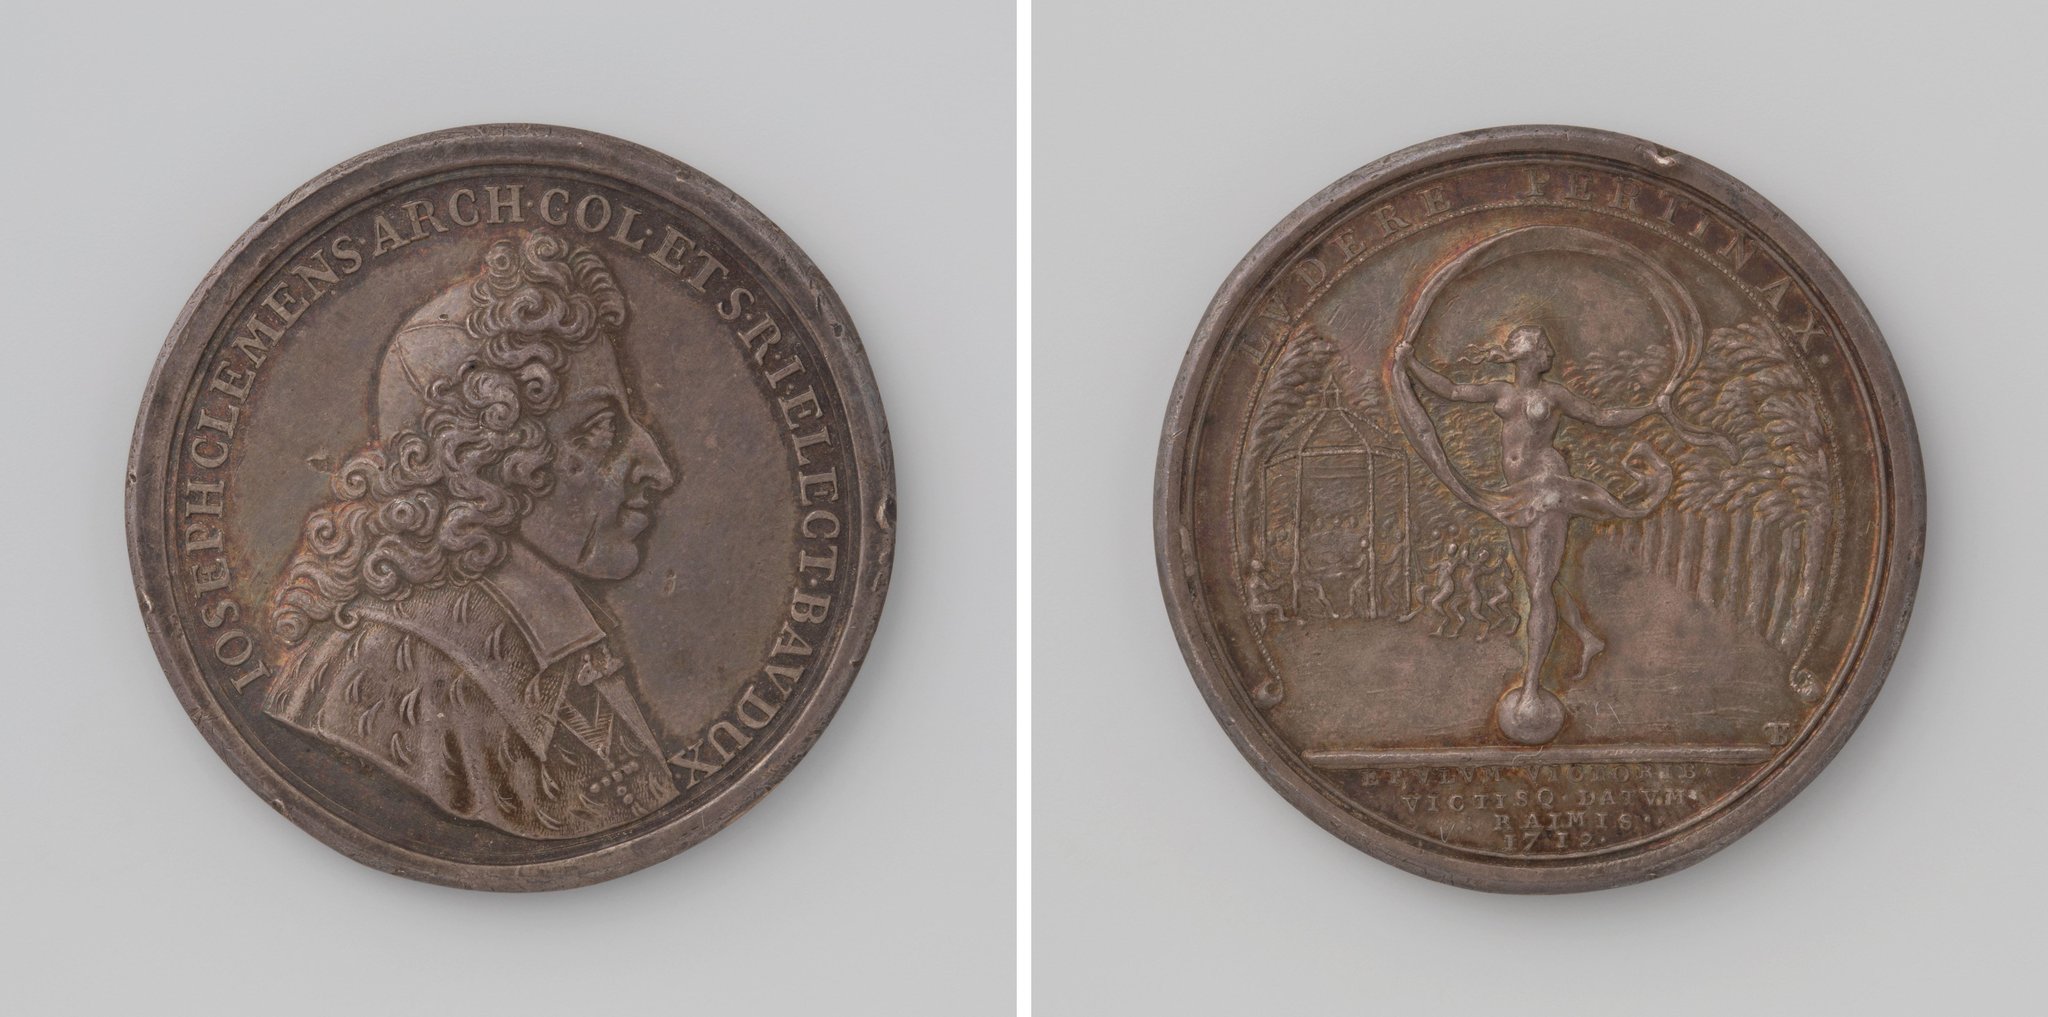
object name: history medal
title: Gastmaal te Reims ter ere van de overwinningen van de Fransen, door Jozef Klemens, aartsbisschop van Keulen aangeboden aan overwinnaars en overwonnenen.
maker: thomas bernard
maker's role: artist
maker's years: 1650-1713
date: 1712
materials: silver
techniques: striking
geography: paris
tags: münchen, bisschop, prins-bisschop, keurvorst, aartsbisschop, keurvorst en aartsbisschop van keulen jozef klemens, reims, spaanse successieoorlog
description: Zilveren penning. Voorzijde: borststuk man binnen omschrift. Keerzijde: Geluk met sluier boven haar hoofd, op achtergrond gastmaal en dansende mensen binnen omschrift; afsnede: opschrift